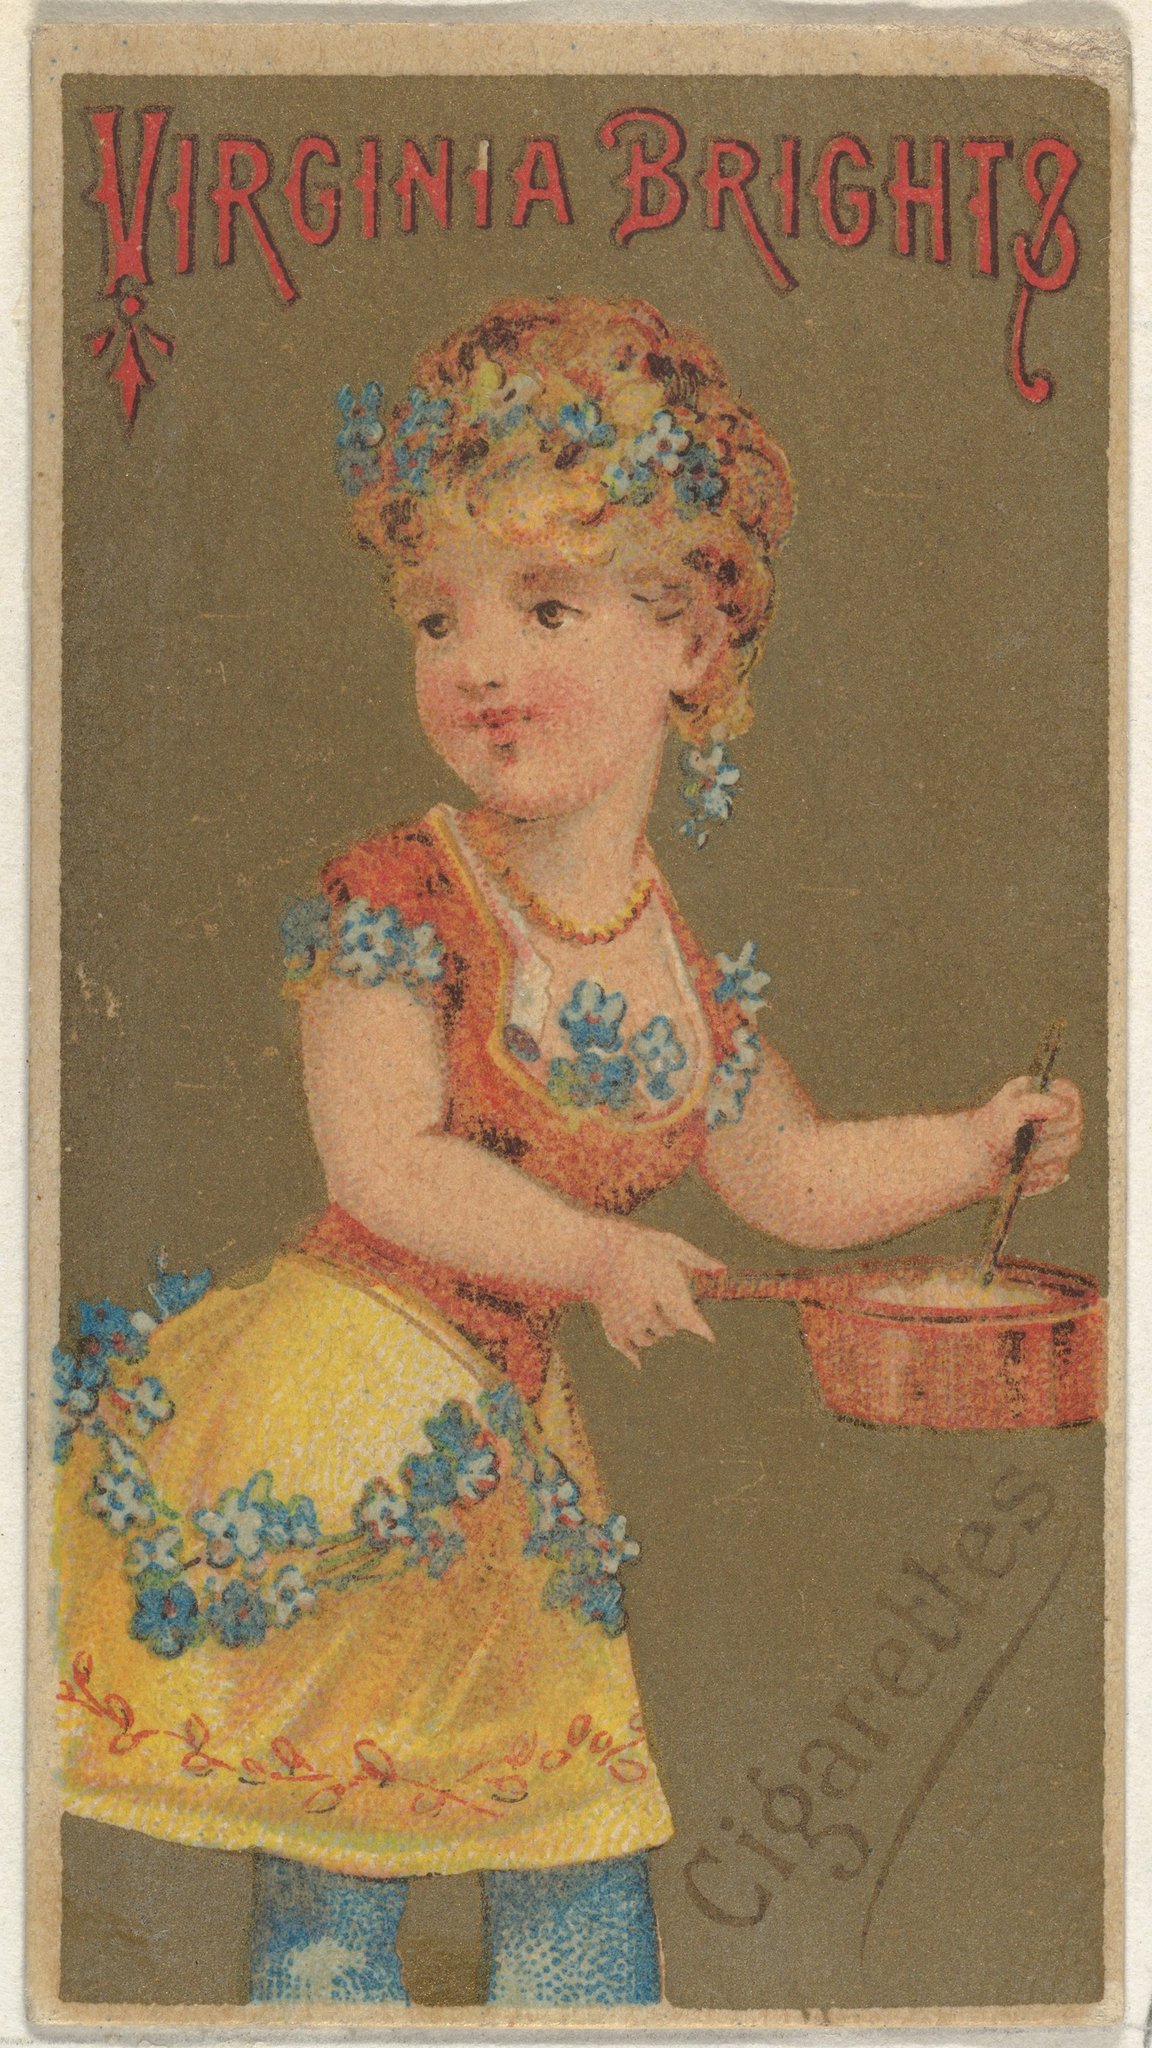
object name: print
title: From the Girls and Children series (N64) promoting Virginia Brights Cigarettes for Allen & Ginter brand tobacco products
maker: allen & ginter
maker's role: publisher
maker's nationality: american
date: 1886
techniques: color lithograph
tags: girls